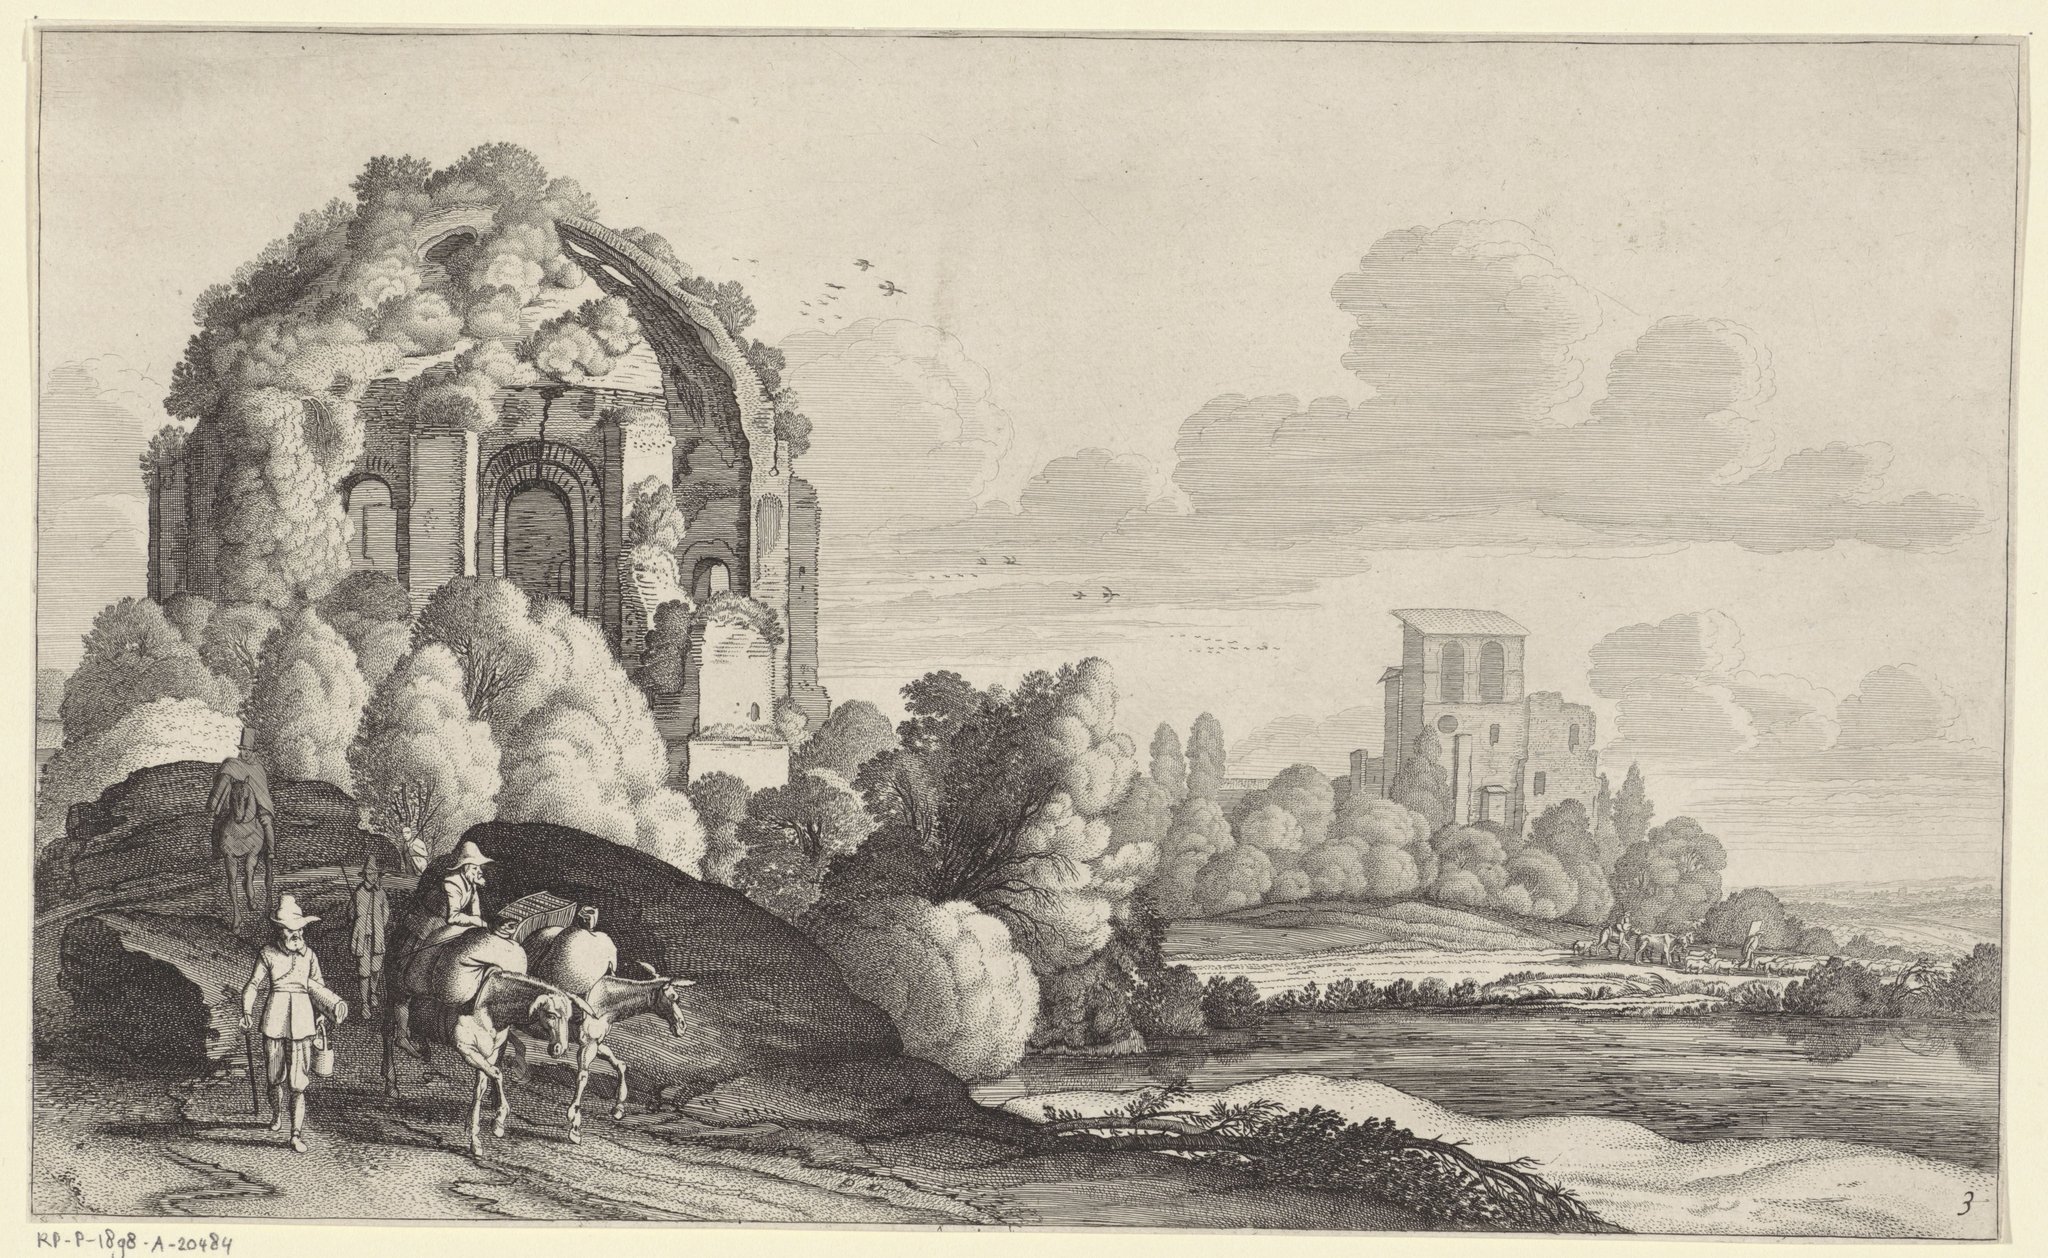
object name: print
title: Reizigers bij de Tempel van Minerva Medica bij Rome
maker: jan van de velde (ii)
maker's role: draughtsman, painter, print maker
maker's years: 1593-1641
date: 1604-1641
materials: paper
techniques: engraving, etching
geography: northern netherlands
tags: pack-animal, landscape with ruins, 'en route', traveller under way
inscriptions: collector's mark: Lugt 964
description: Reizigers met pakezels bij de Tempel van Minerva Medica bij Rome. Derde prent uit een serie van vier.